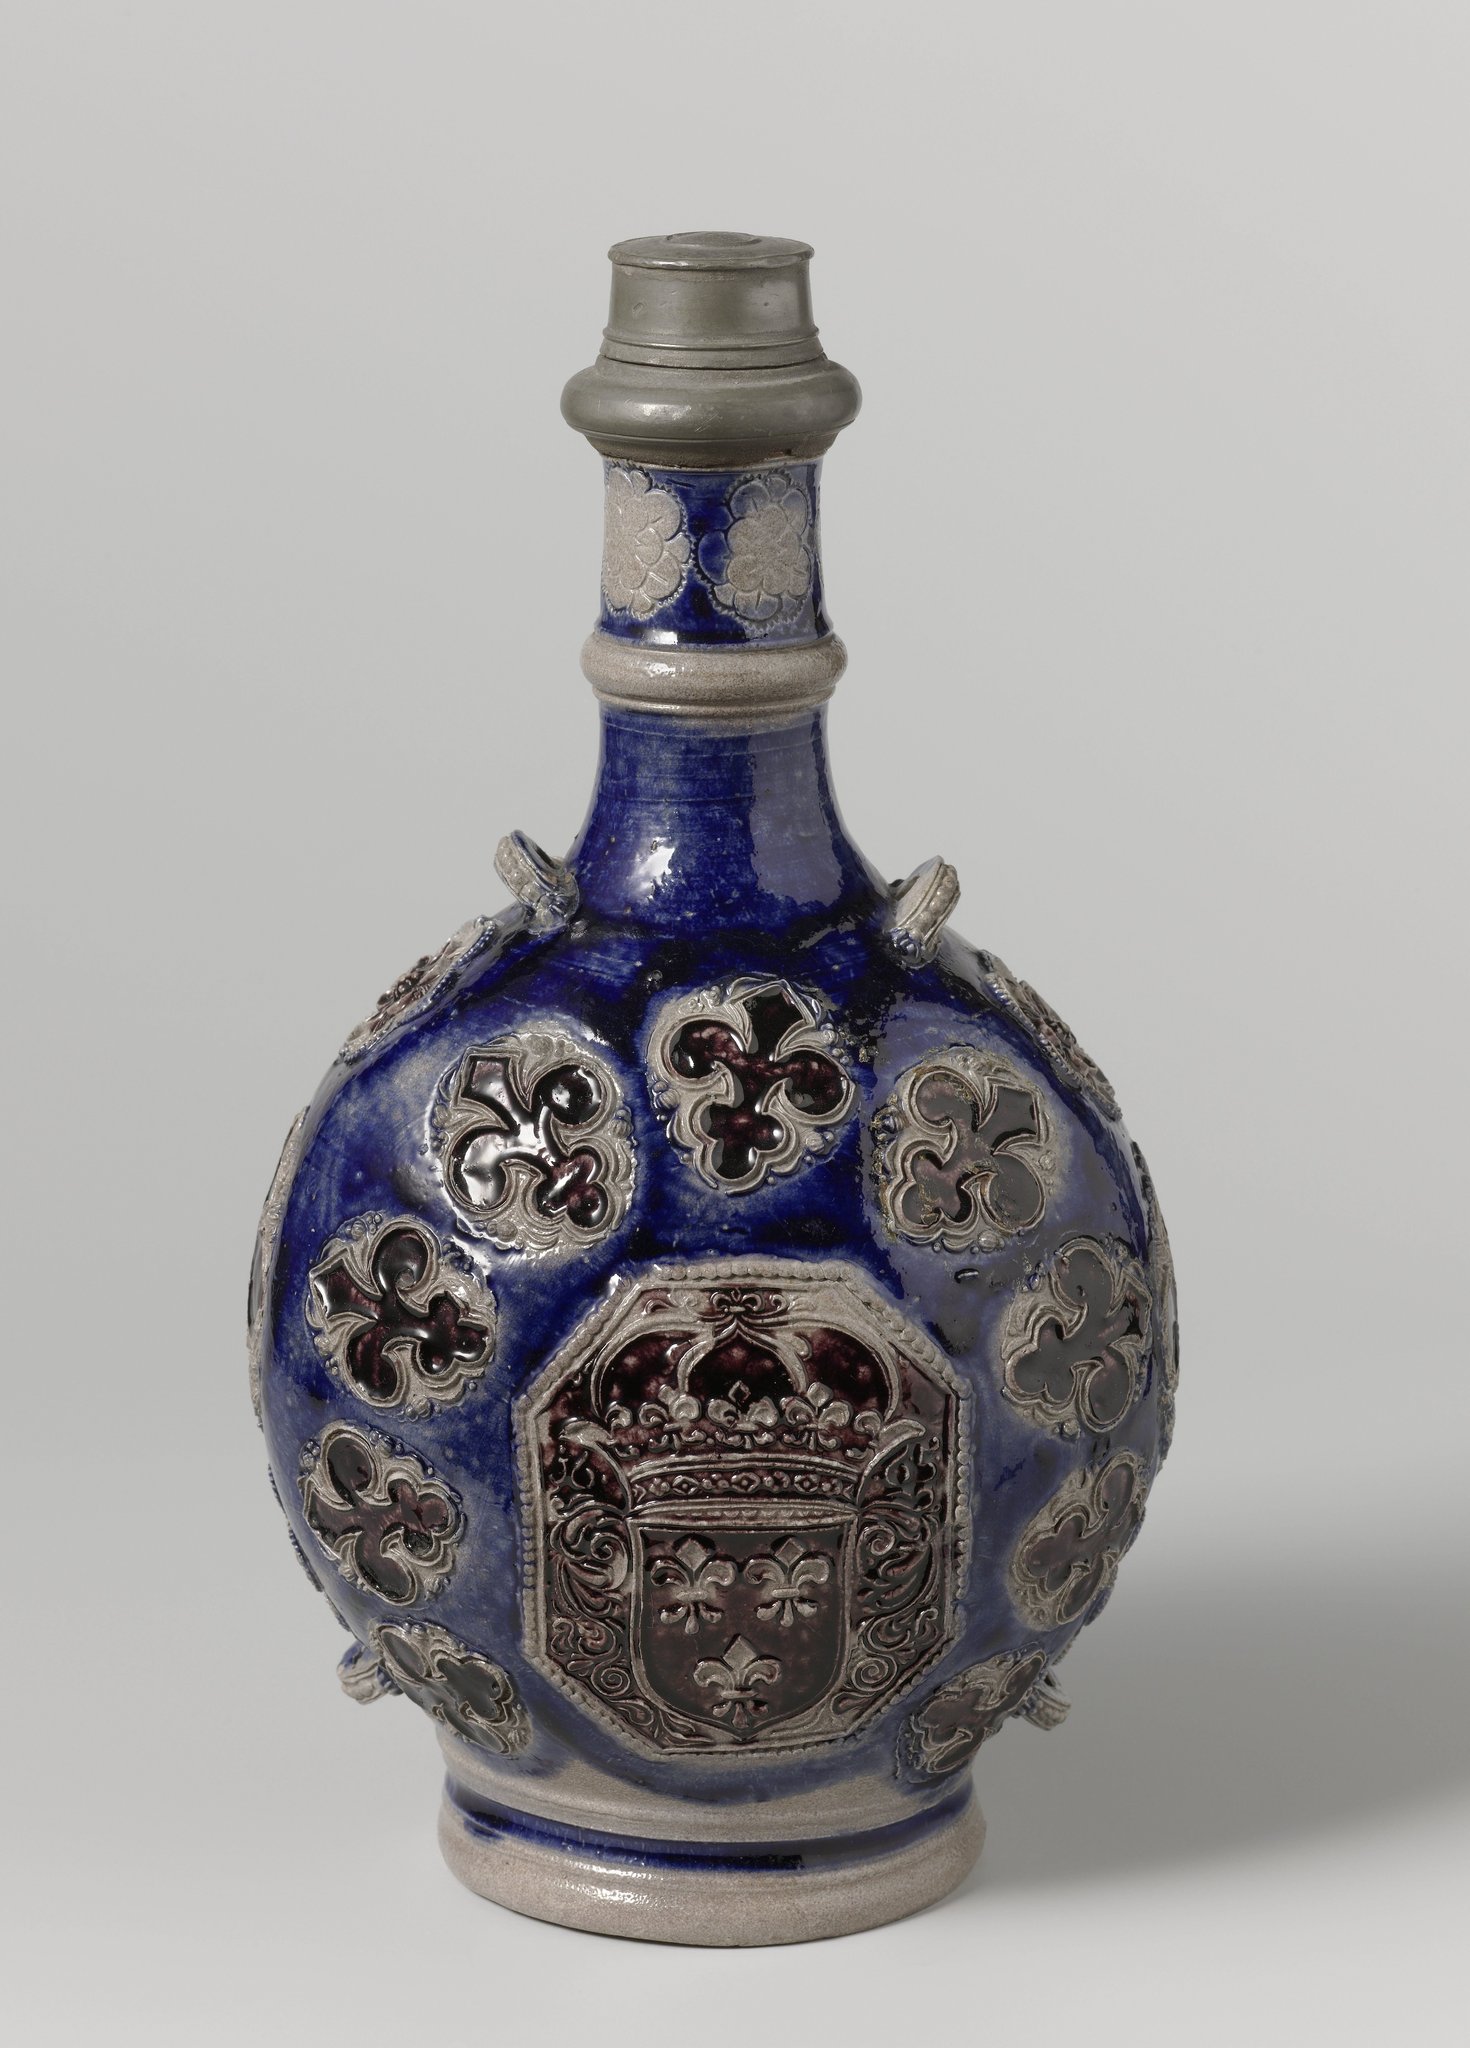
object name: pilgrim bottle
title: Jug (pilgrim flask) with the coat of arms of France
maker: Anonymous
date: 1665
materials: cobalt, glaze, mineral, stoneware, tin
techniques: printing, firing, forming, relief, turning, vitrification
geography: grenzau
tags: coat of arms (as symbol of the state, etc.), fleur-de-lis ~ ornament, france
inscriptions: date: ‘1665’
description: Westerwald stoneware is recognizable by its decoration of cobalt blue on grey. Unusual features of this bottle are the fleurs-de-lys and the dark violet in the coat of arms. This colour, derived from added manganic oxide, first came into use during the mid-17th century. The lily motifs around the arms of France on the body suggest that the bottle was made for the French market.